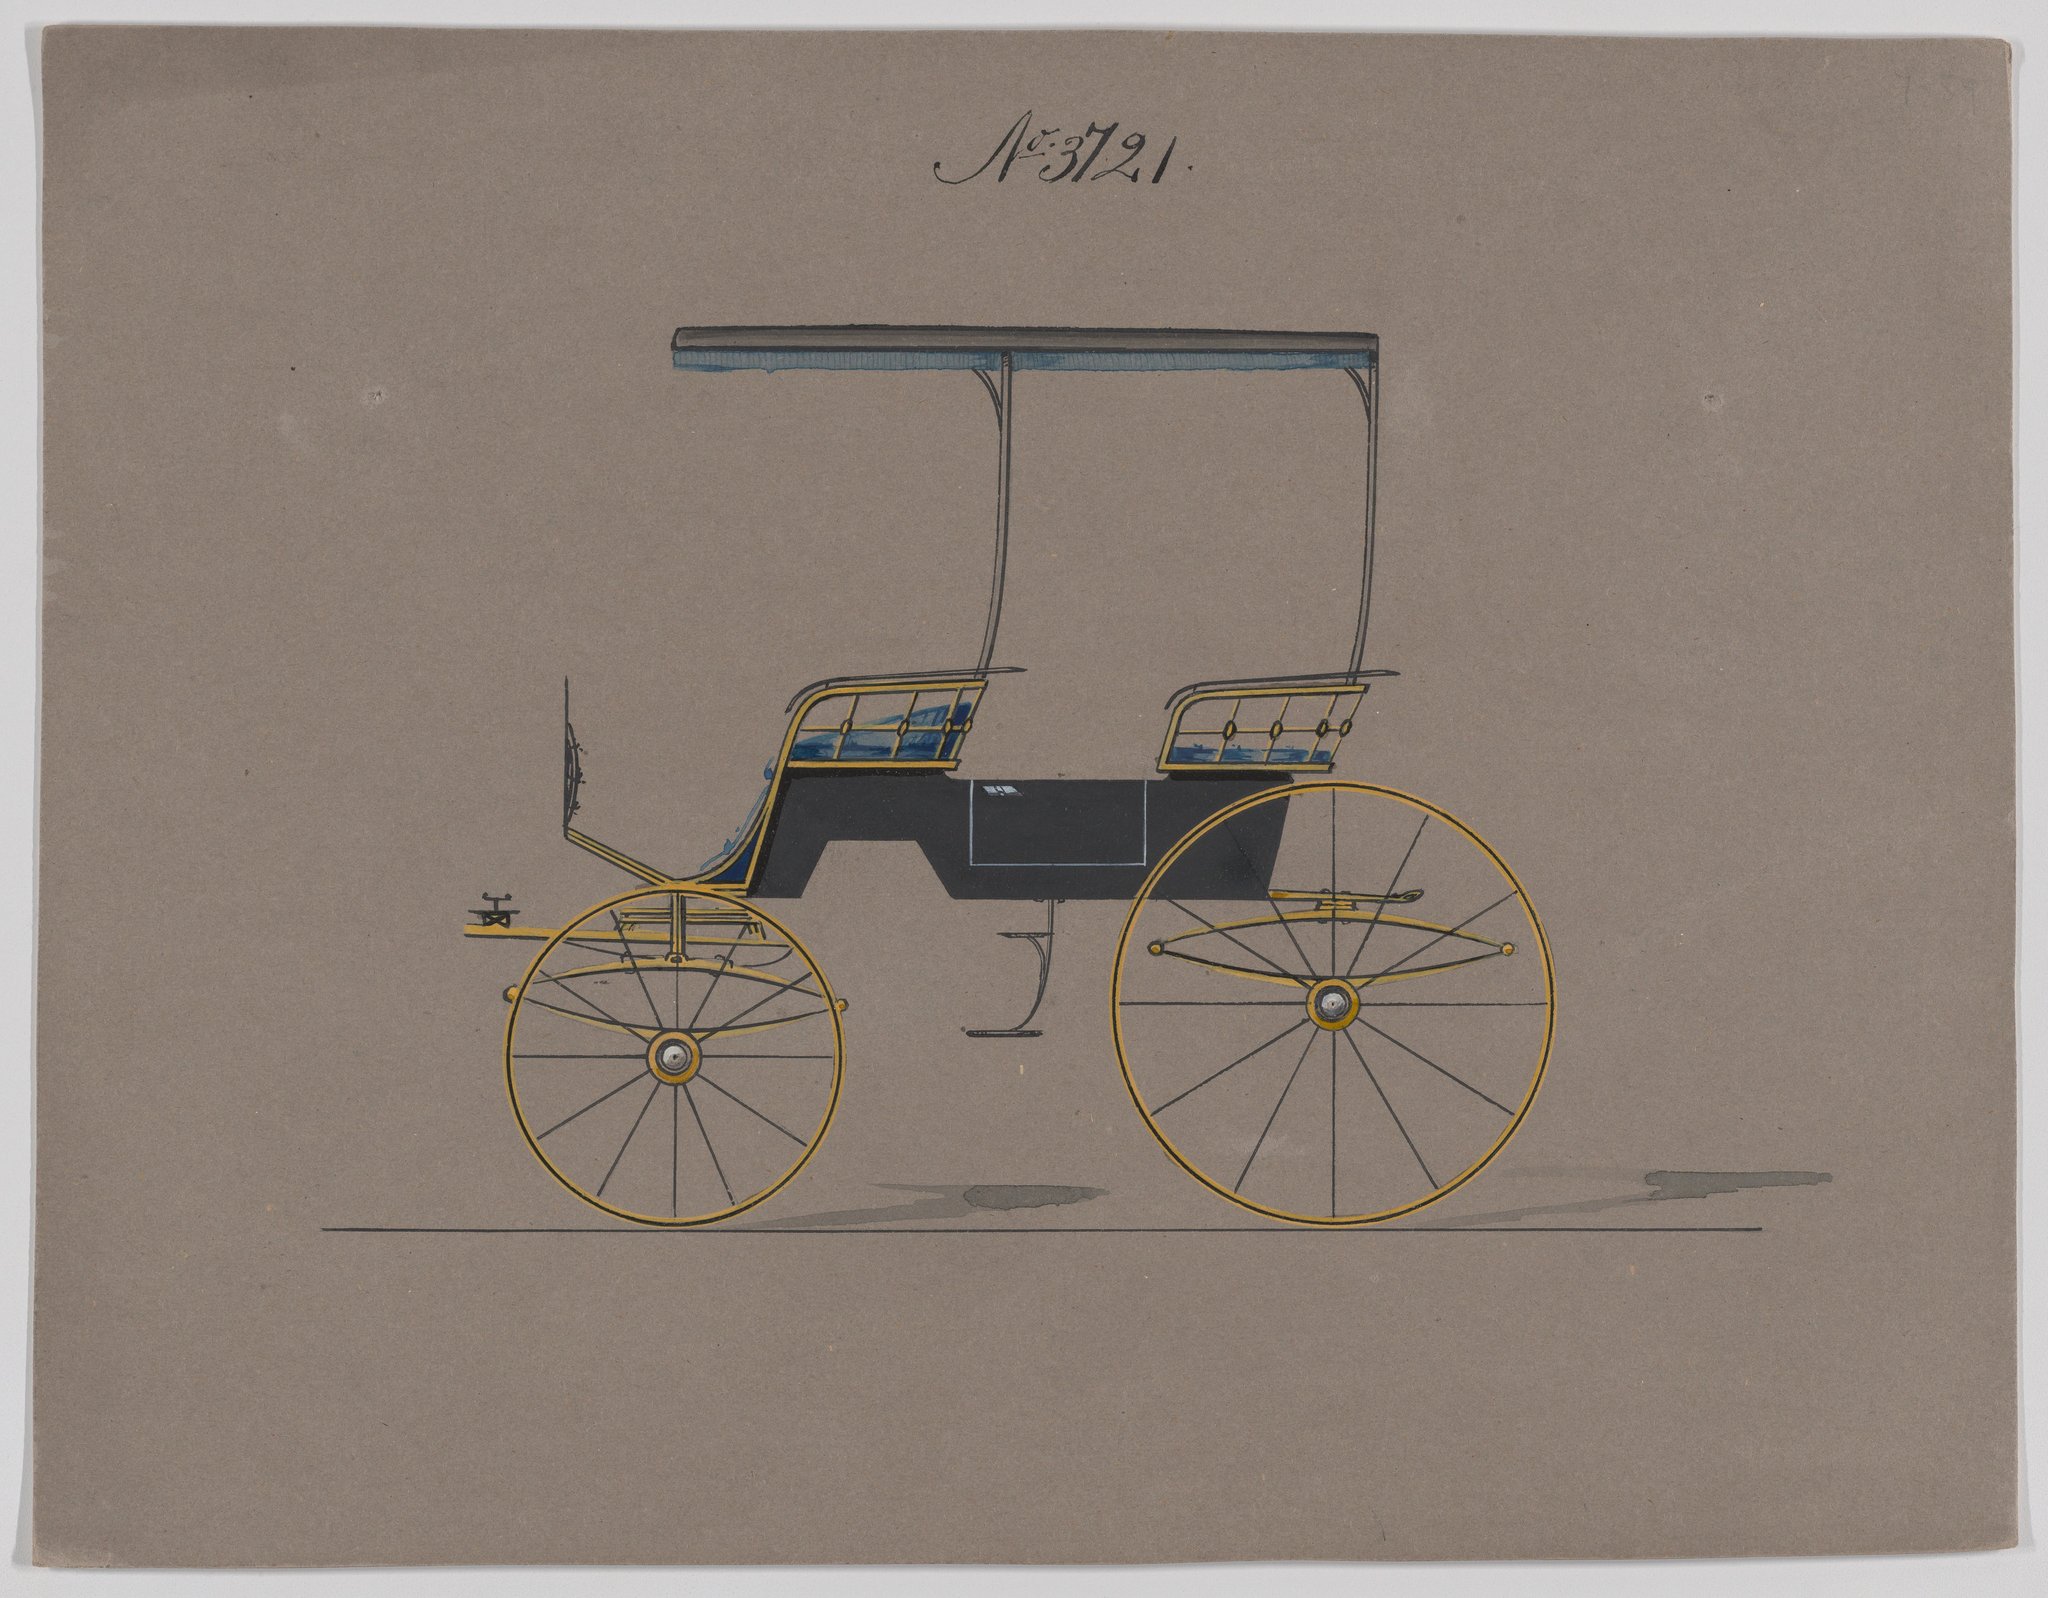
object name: drawing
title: Design for Canopy Top Phaeton, no. 3721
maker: brewster & co.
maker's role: manufacturer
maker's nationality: american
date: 1881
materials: gouache, gum arabic, ink, watercolor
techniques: pen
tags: carriages